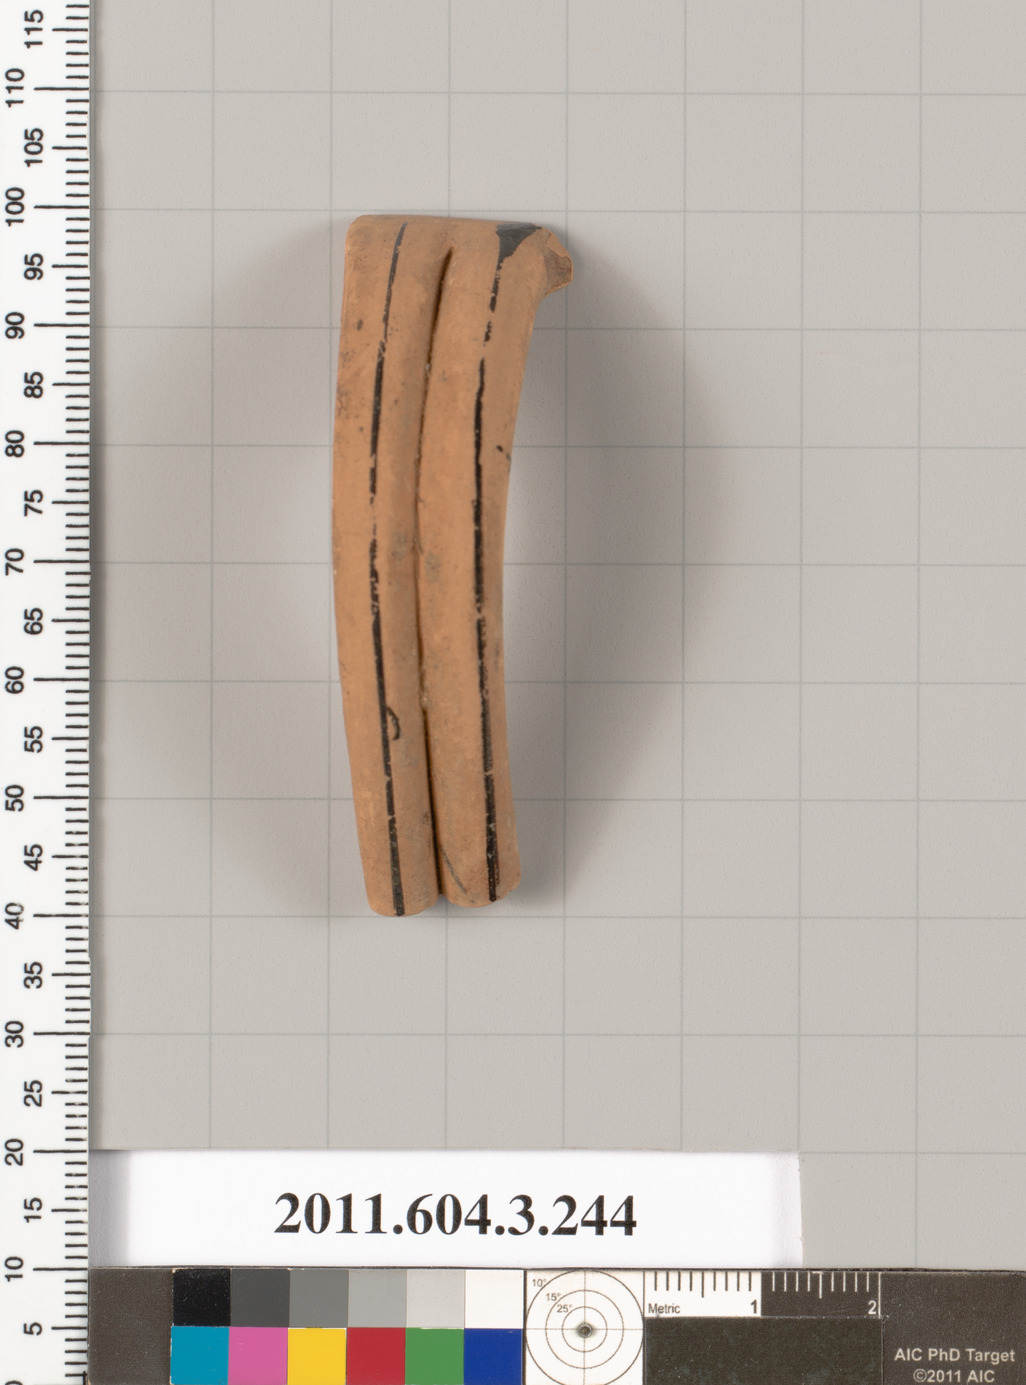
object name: oinochoe fragment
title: Terracotta fragment of an oinochoe (jug)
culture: greek, attic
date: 534-468 BCE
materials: terracotta